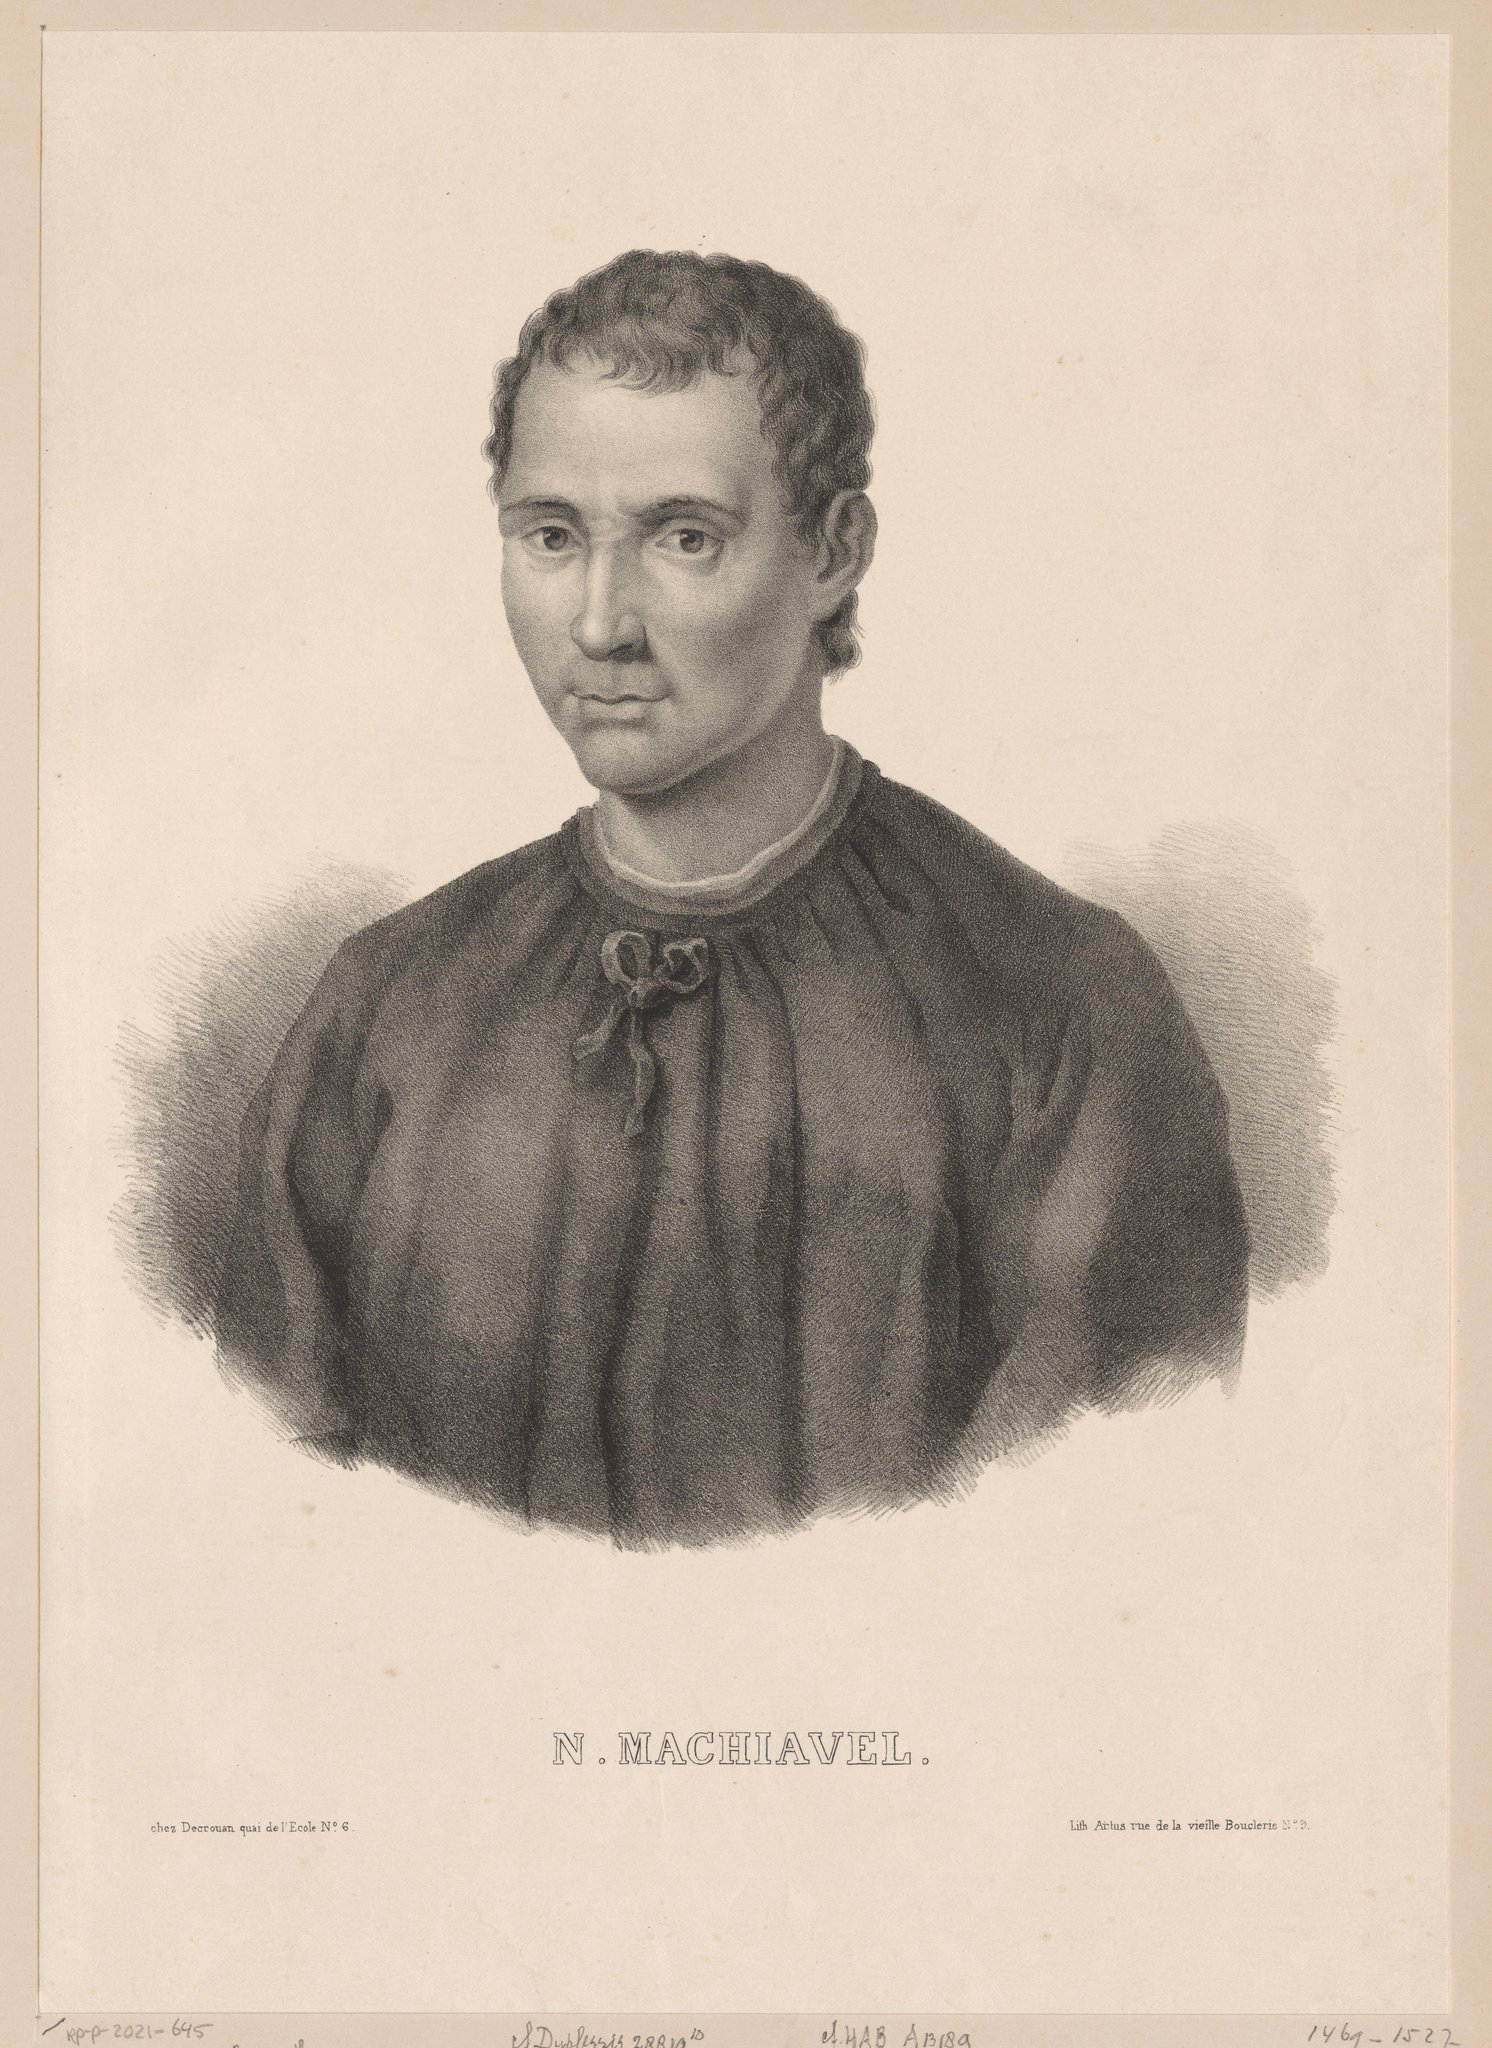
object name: print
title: Portret van Niccolò Machiavelli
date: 1829-1857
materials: paper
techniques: lithograph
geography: paris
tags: politician, historical persons, scholar, philosopher (+ portrait of scholar, scientist)